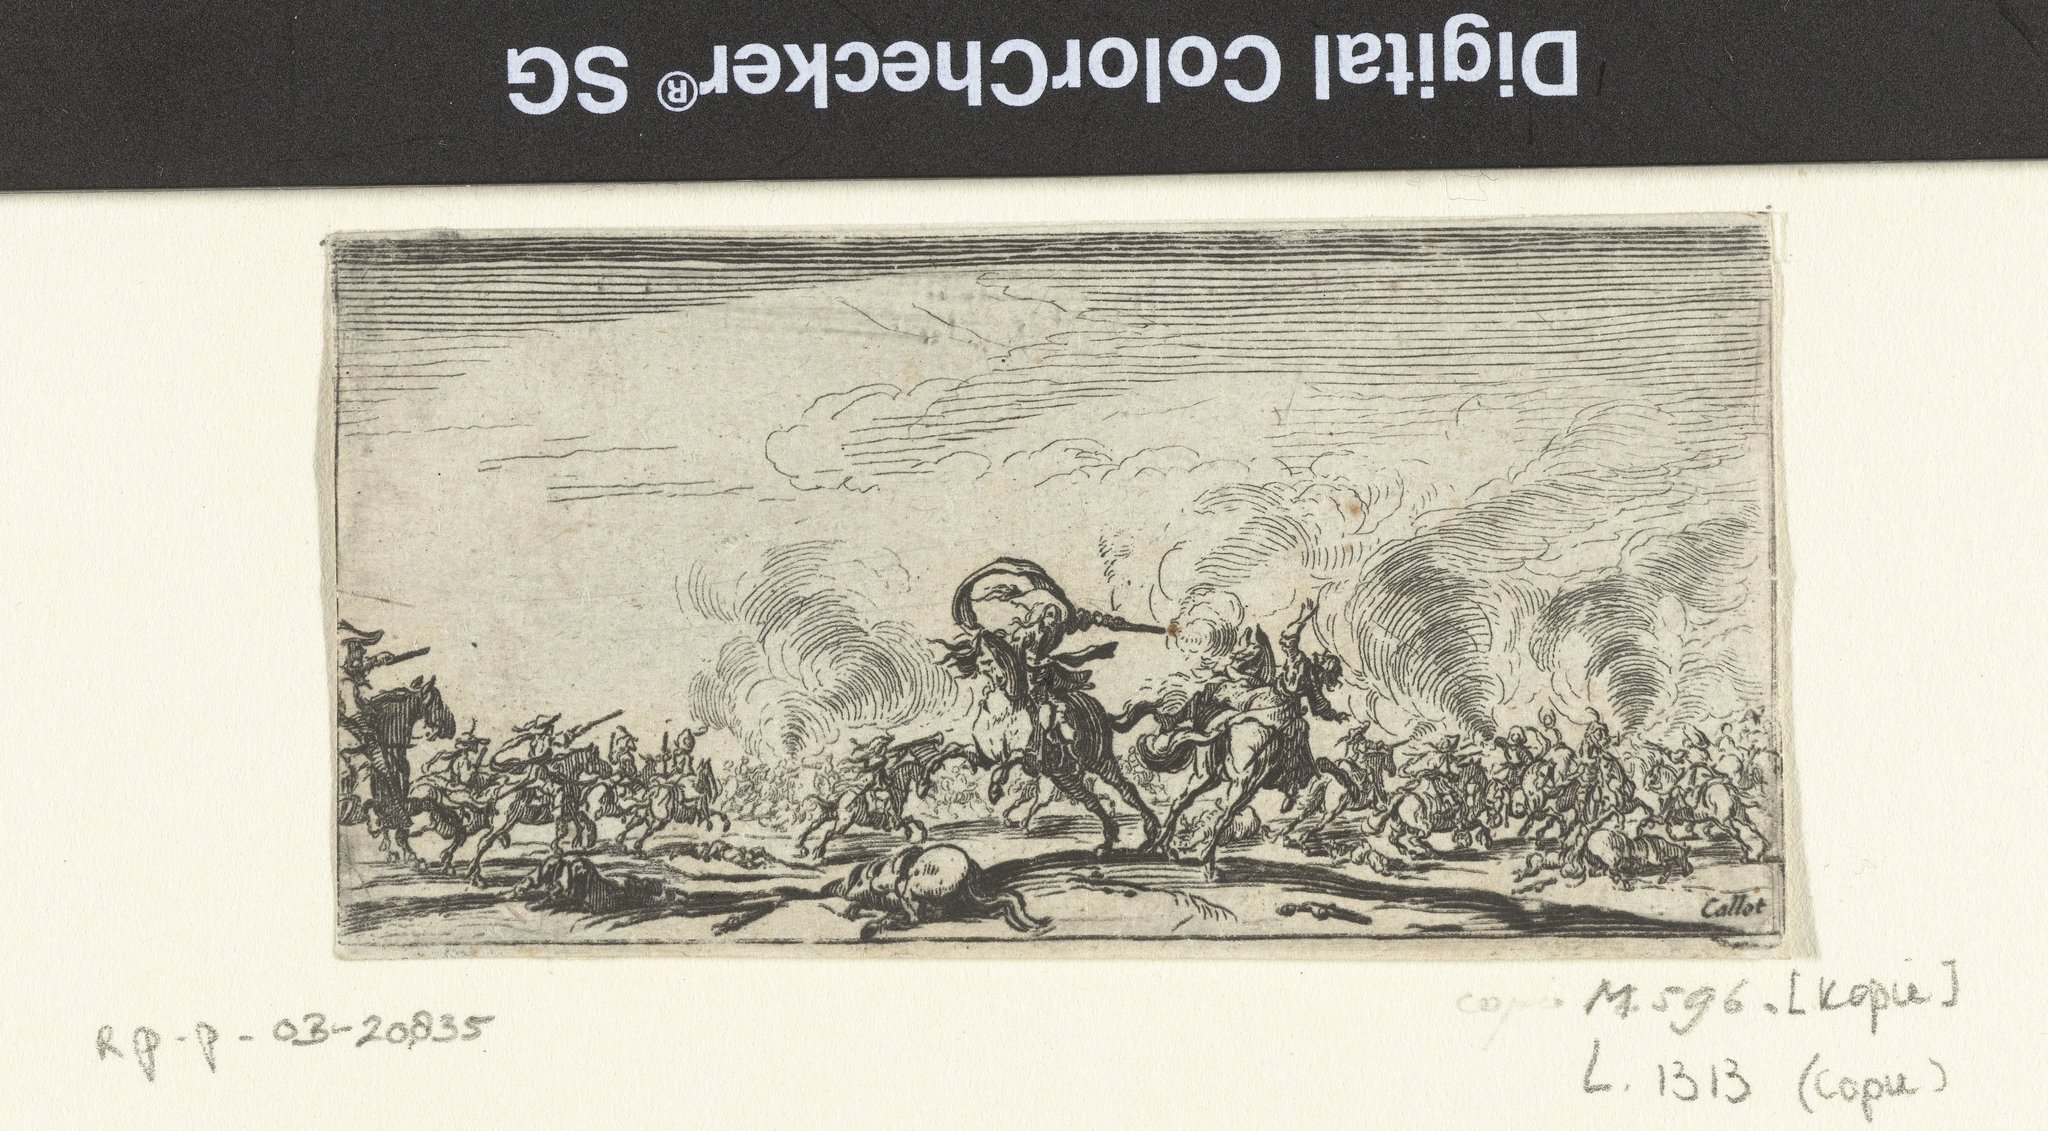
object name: print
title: Cavaleriegevecht met pistolen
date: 1633-1680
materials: paper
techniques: etching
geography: amsterdam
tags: warfare; military affairs (+ cavalry, horsemen), hand-to-hand fighting (~ battle), firearms (with name)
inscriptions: collector's mark: Lugt 240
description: In een ruitergevecht bestrijden de ruiters elkaar met pistolen.